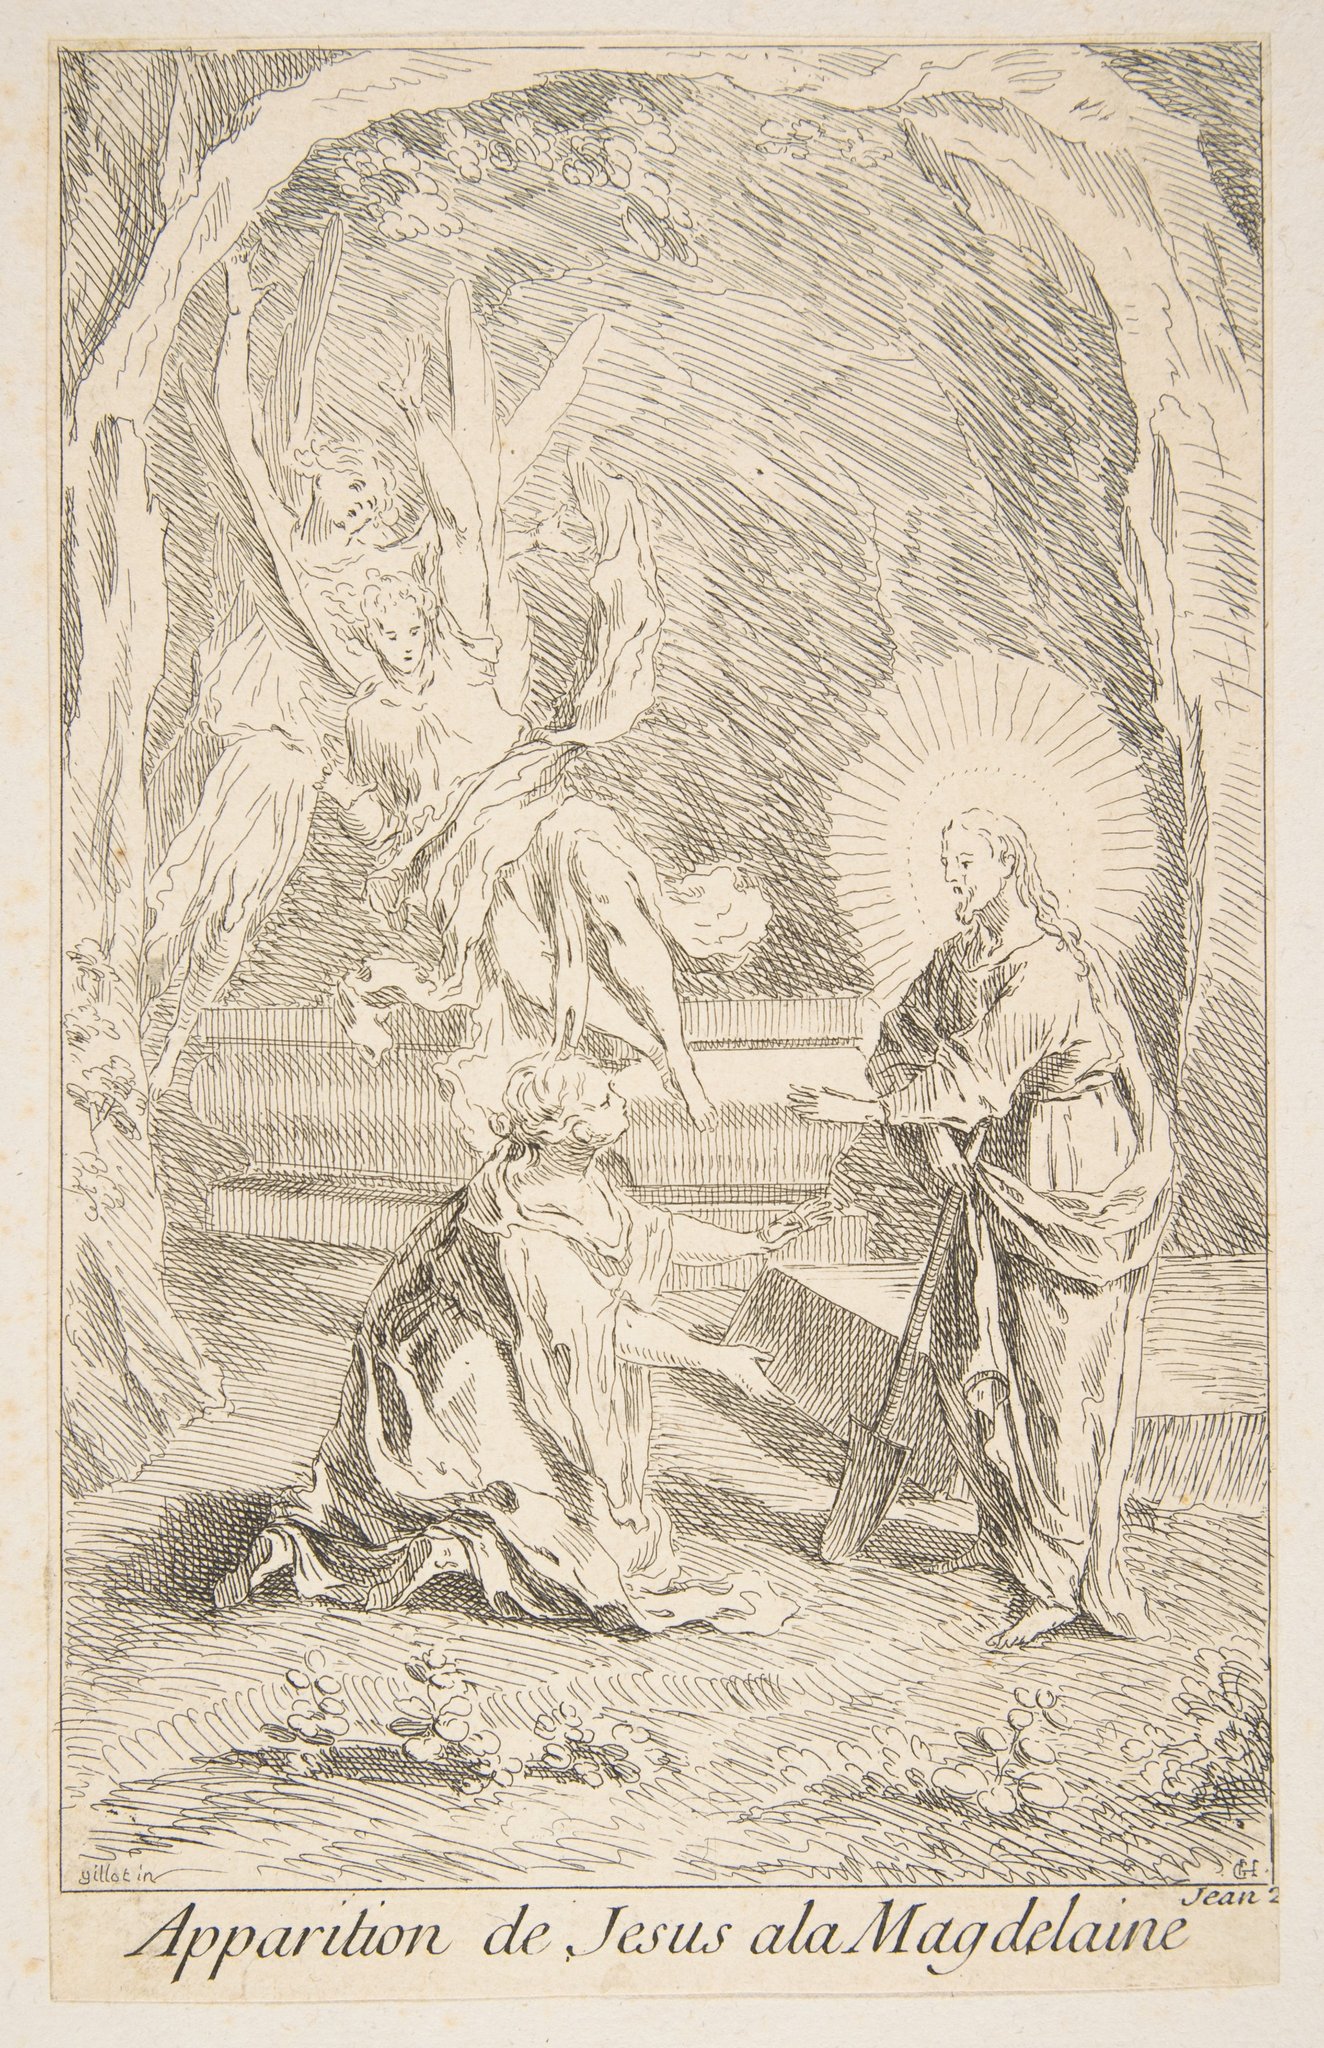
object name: print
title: Christ appearing to Mary Magdelen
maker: claude gillot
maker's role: artist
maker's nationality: french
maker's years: 1673-1722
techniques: etching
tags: christ,mary magdalene